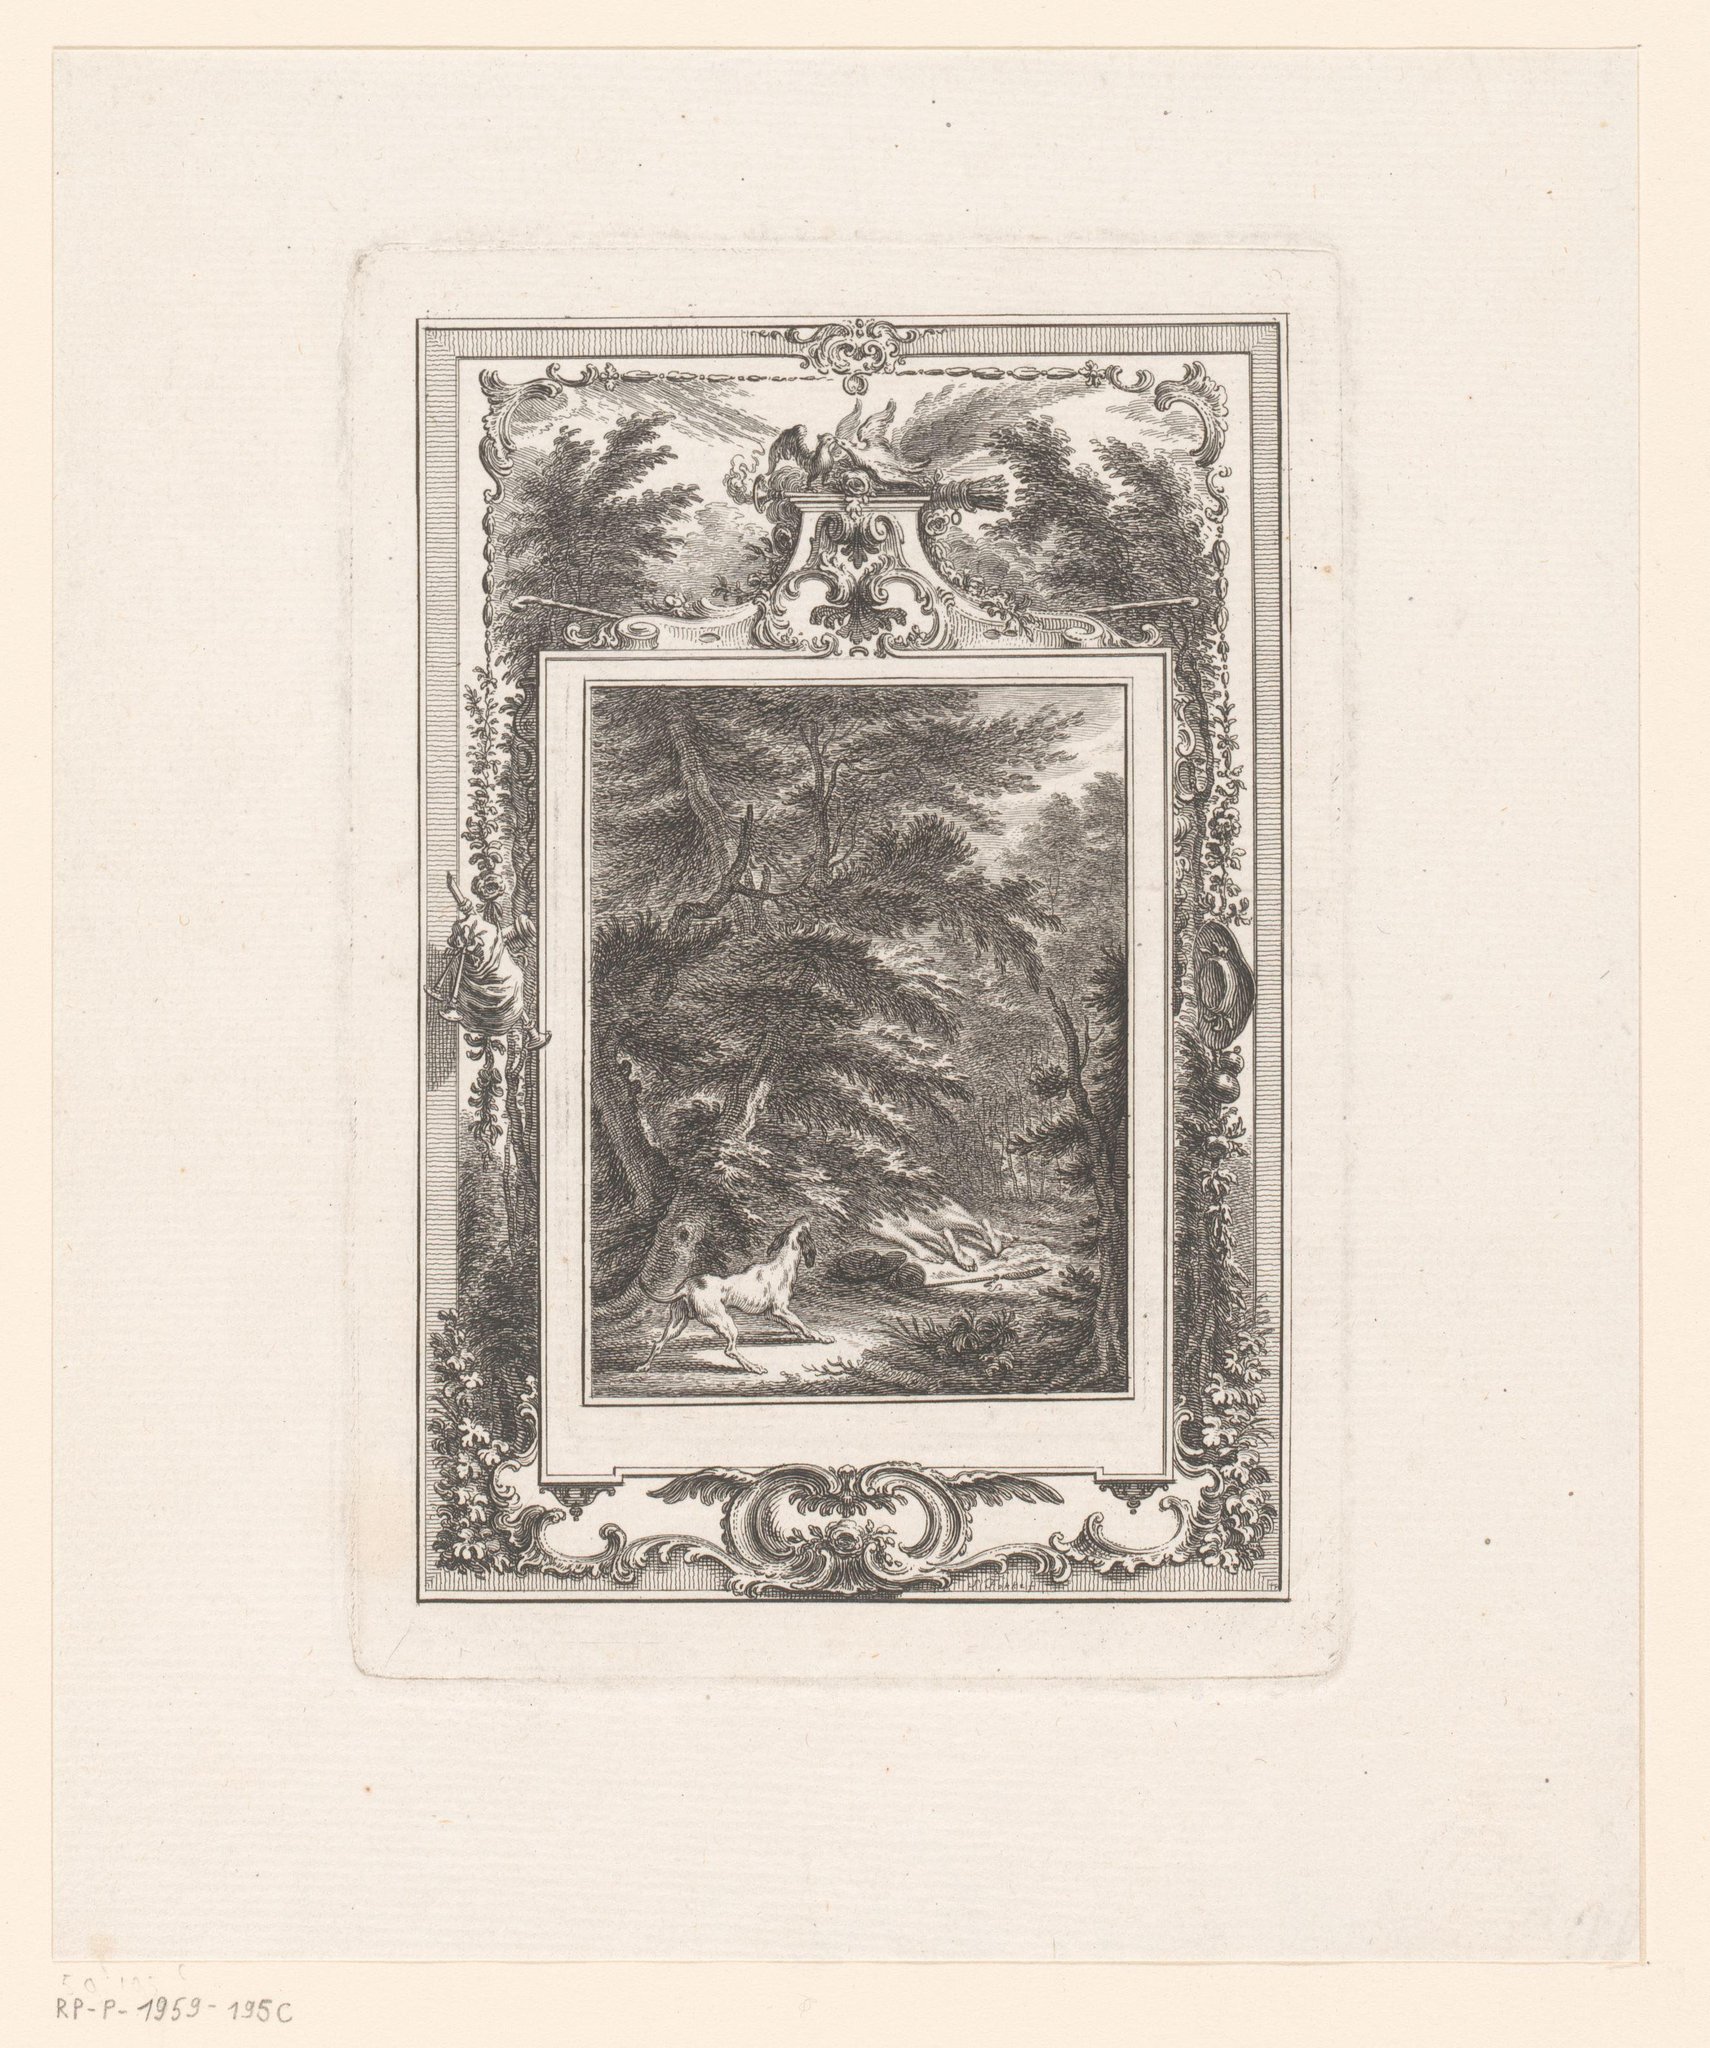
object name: print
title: Les amours pastorales de Daphnis et de Chloé avec figures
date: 1718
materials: paper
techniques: etching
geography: paris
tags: daphnis (in greek mythology a shepherd who invented pastoral poetry, chloe, coitus, cohabiting, sexual intercourse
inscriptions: collector's mark: Lugt 2228, collector's mark: Lugt 2760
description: Prent uit Longus. Les amours pastorales de Daphnis et de Chloé, avec figures. Parijs: s.n., 1718.